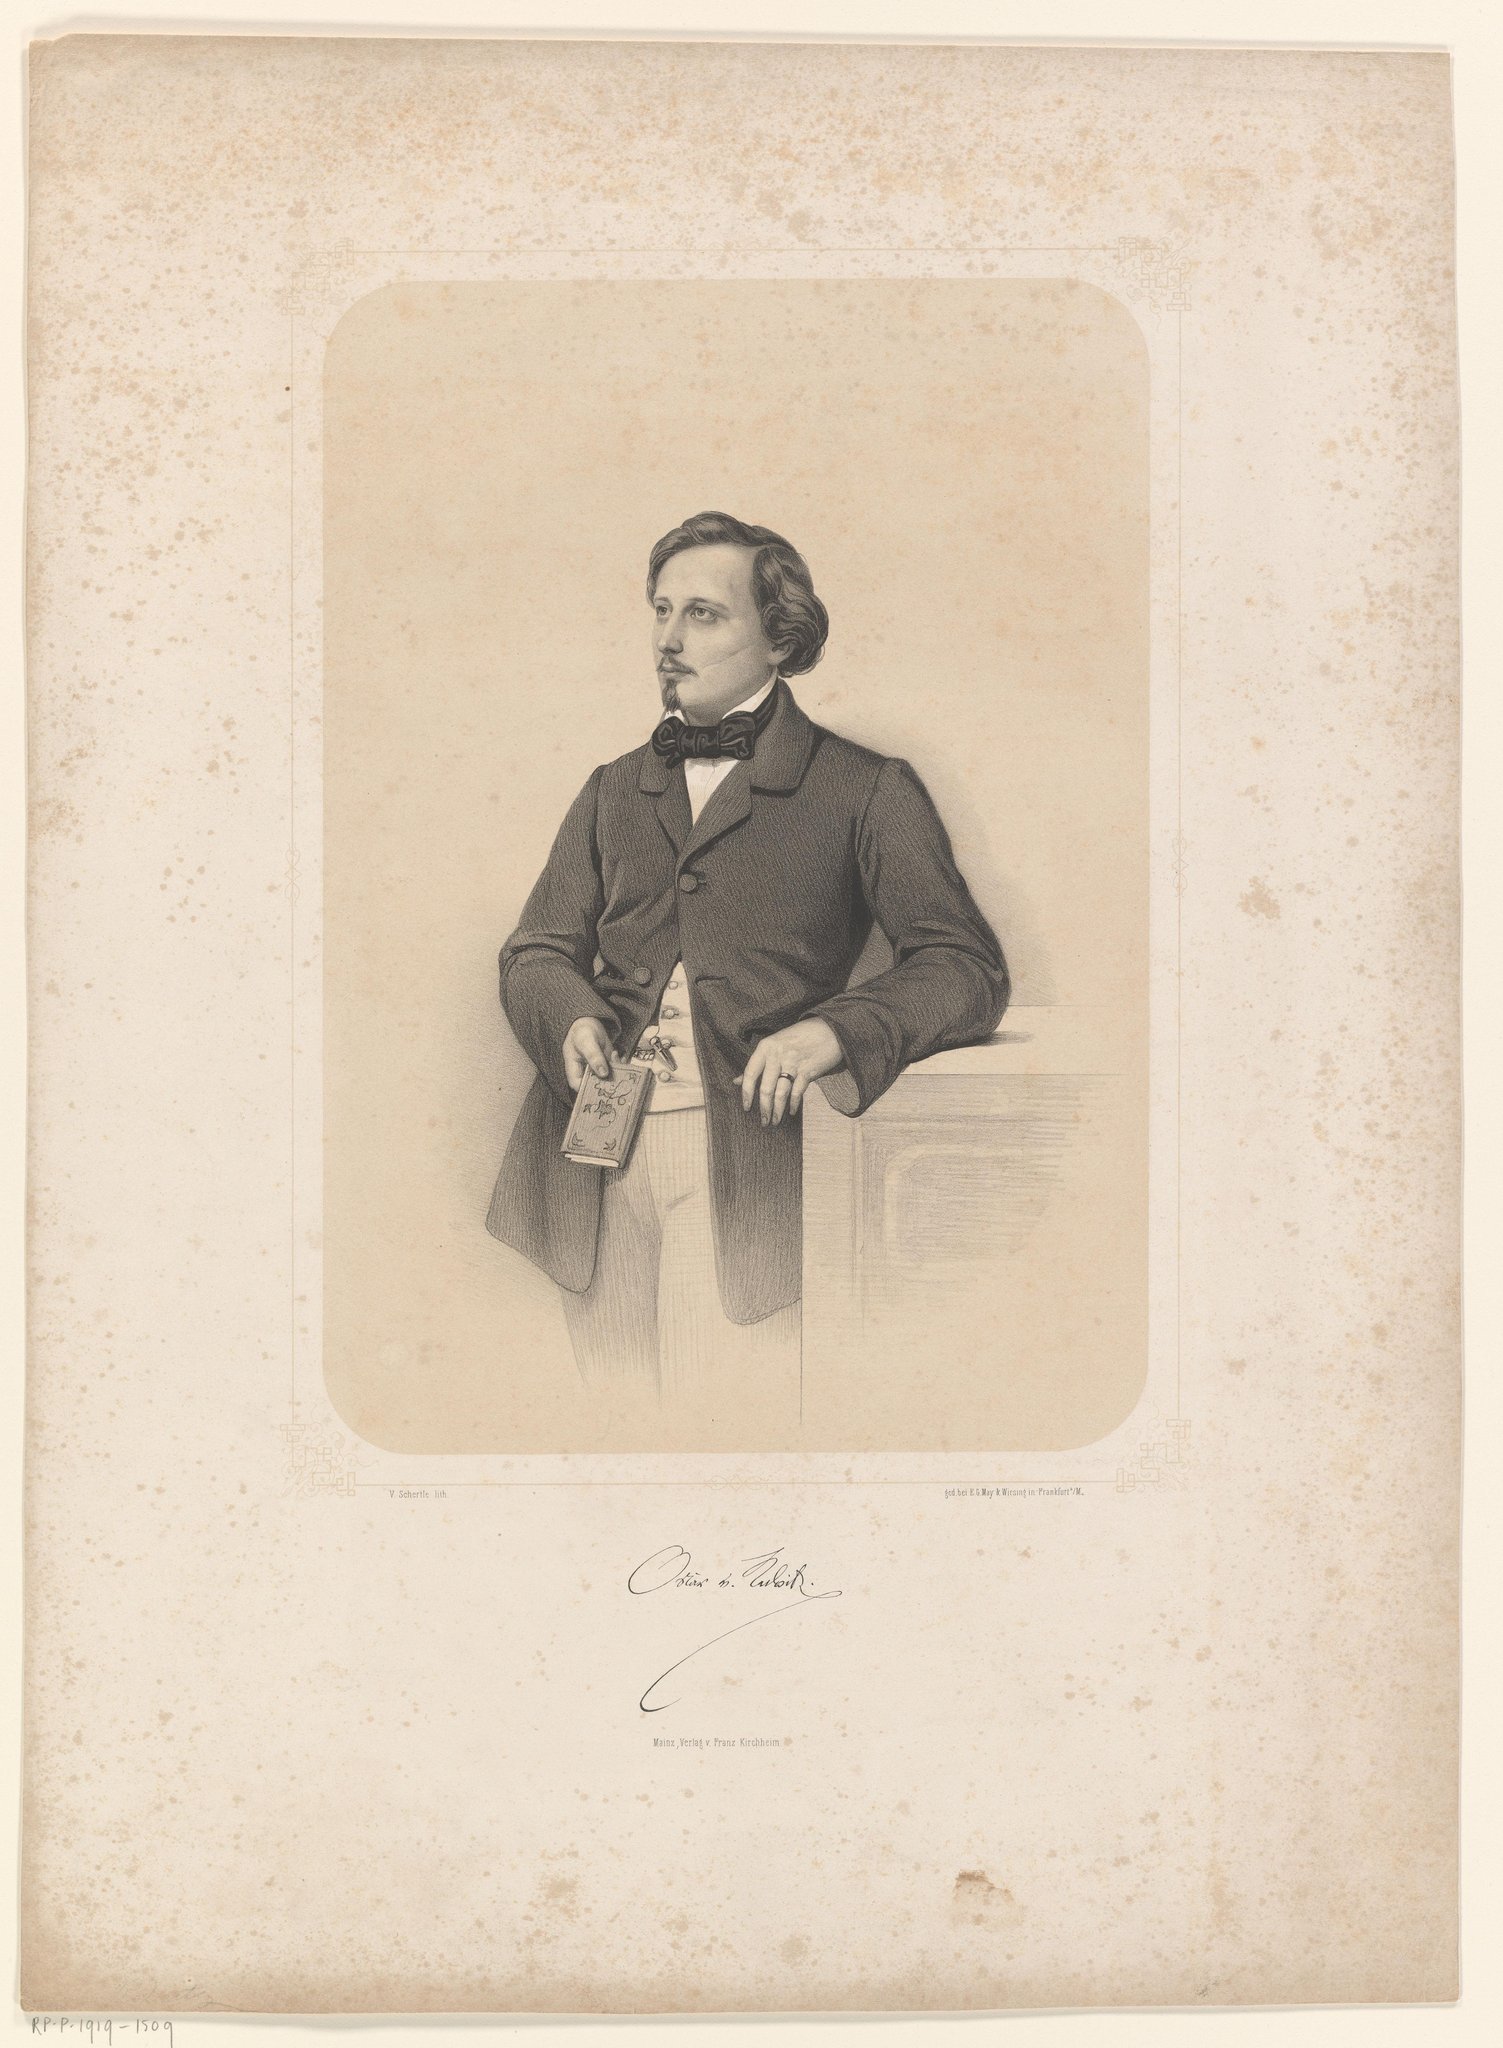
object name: print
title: Portret van Oskar von Redwitz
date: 1819-1885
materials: paper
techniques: tone lithography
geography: frankfurt am main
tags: adult man, historical persons, book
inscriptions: collector's mark: Lugt 2228, check stamp